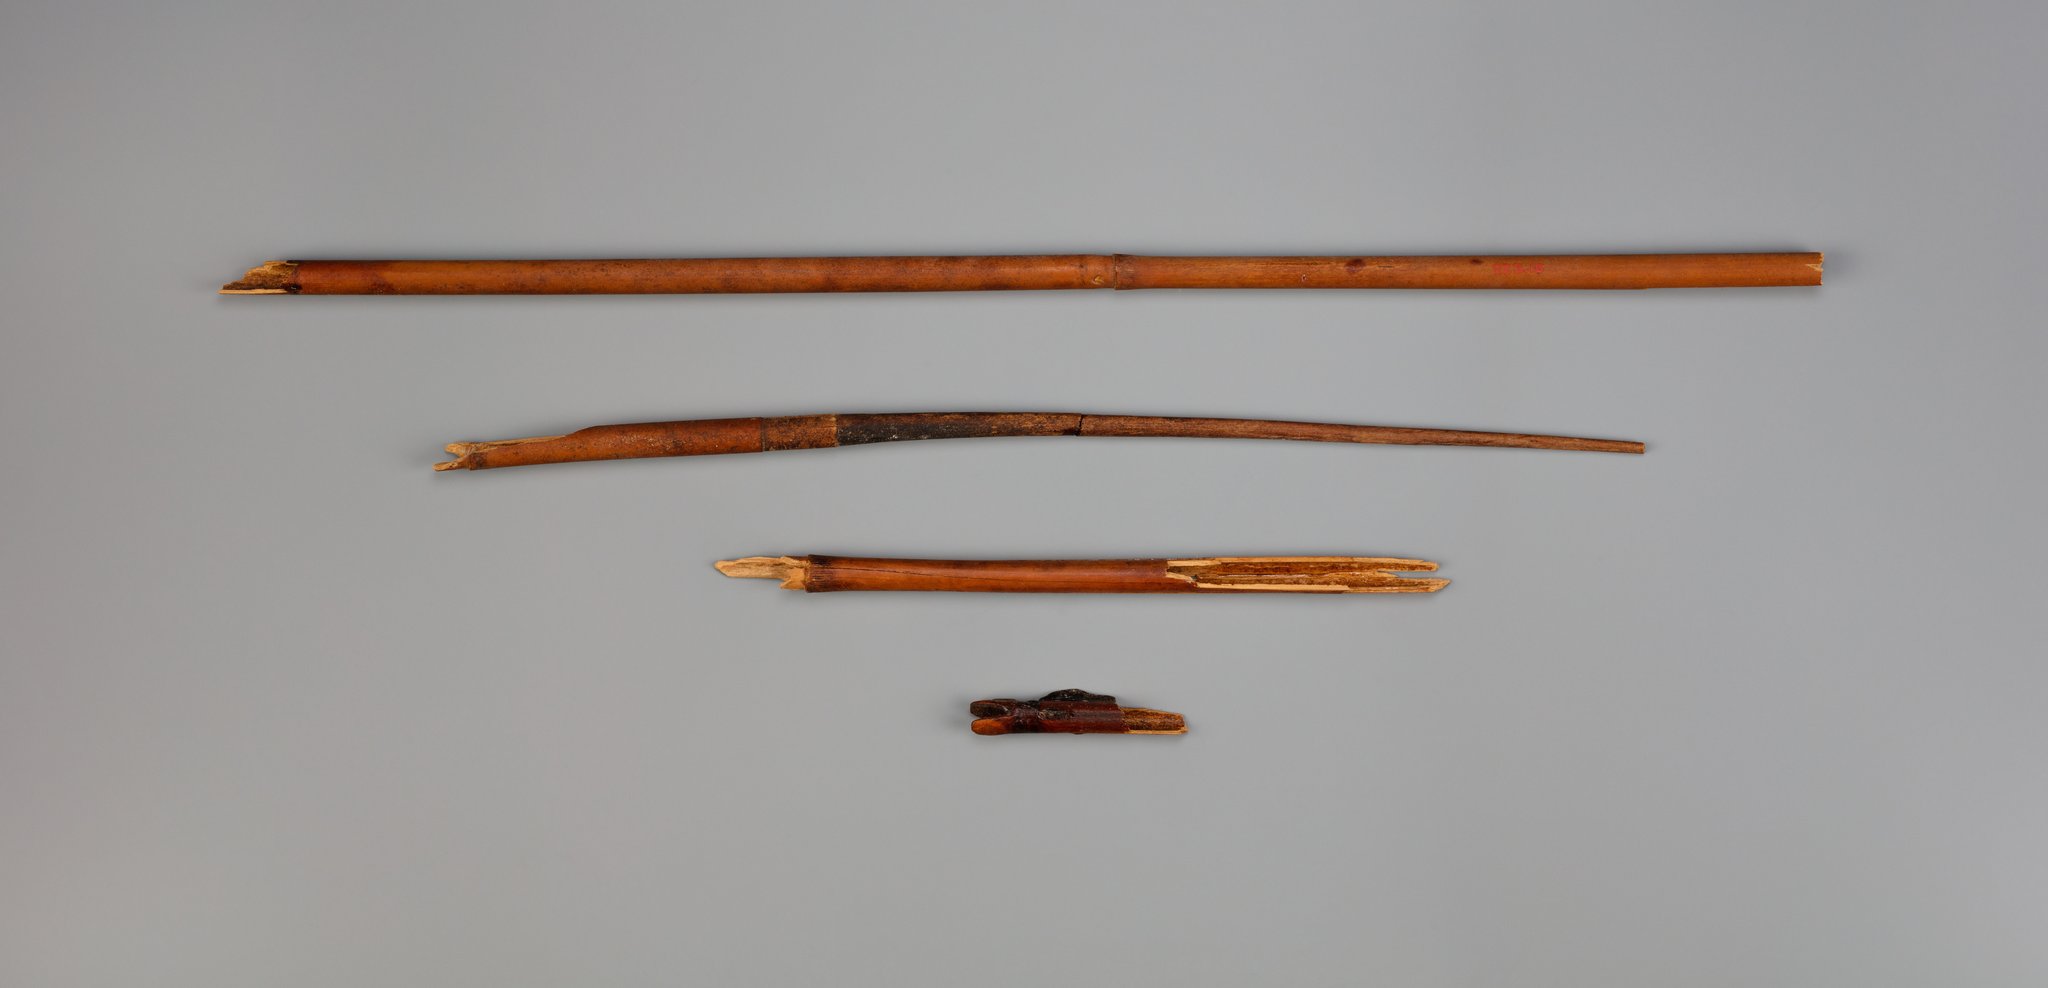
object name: arrow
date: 2030-1640 BCE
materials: feather, wood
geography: egypt